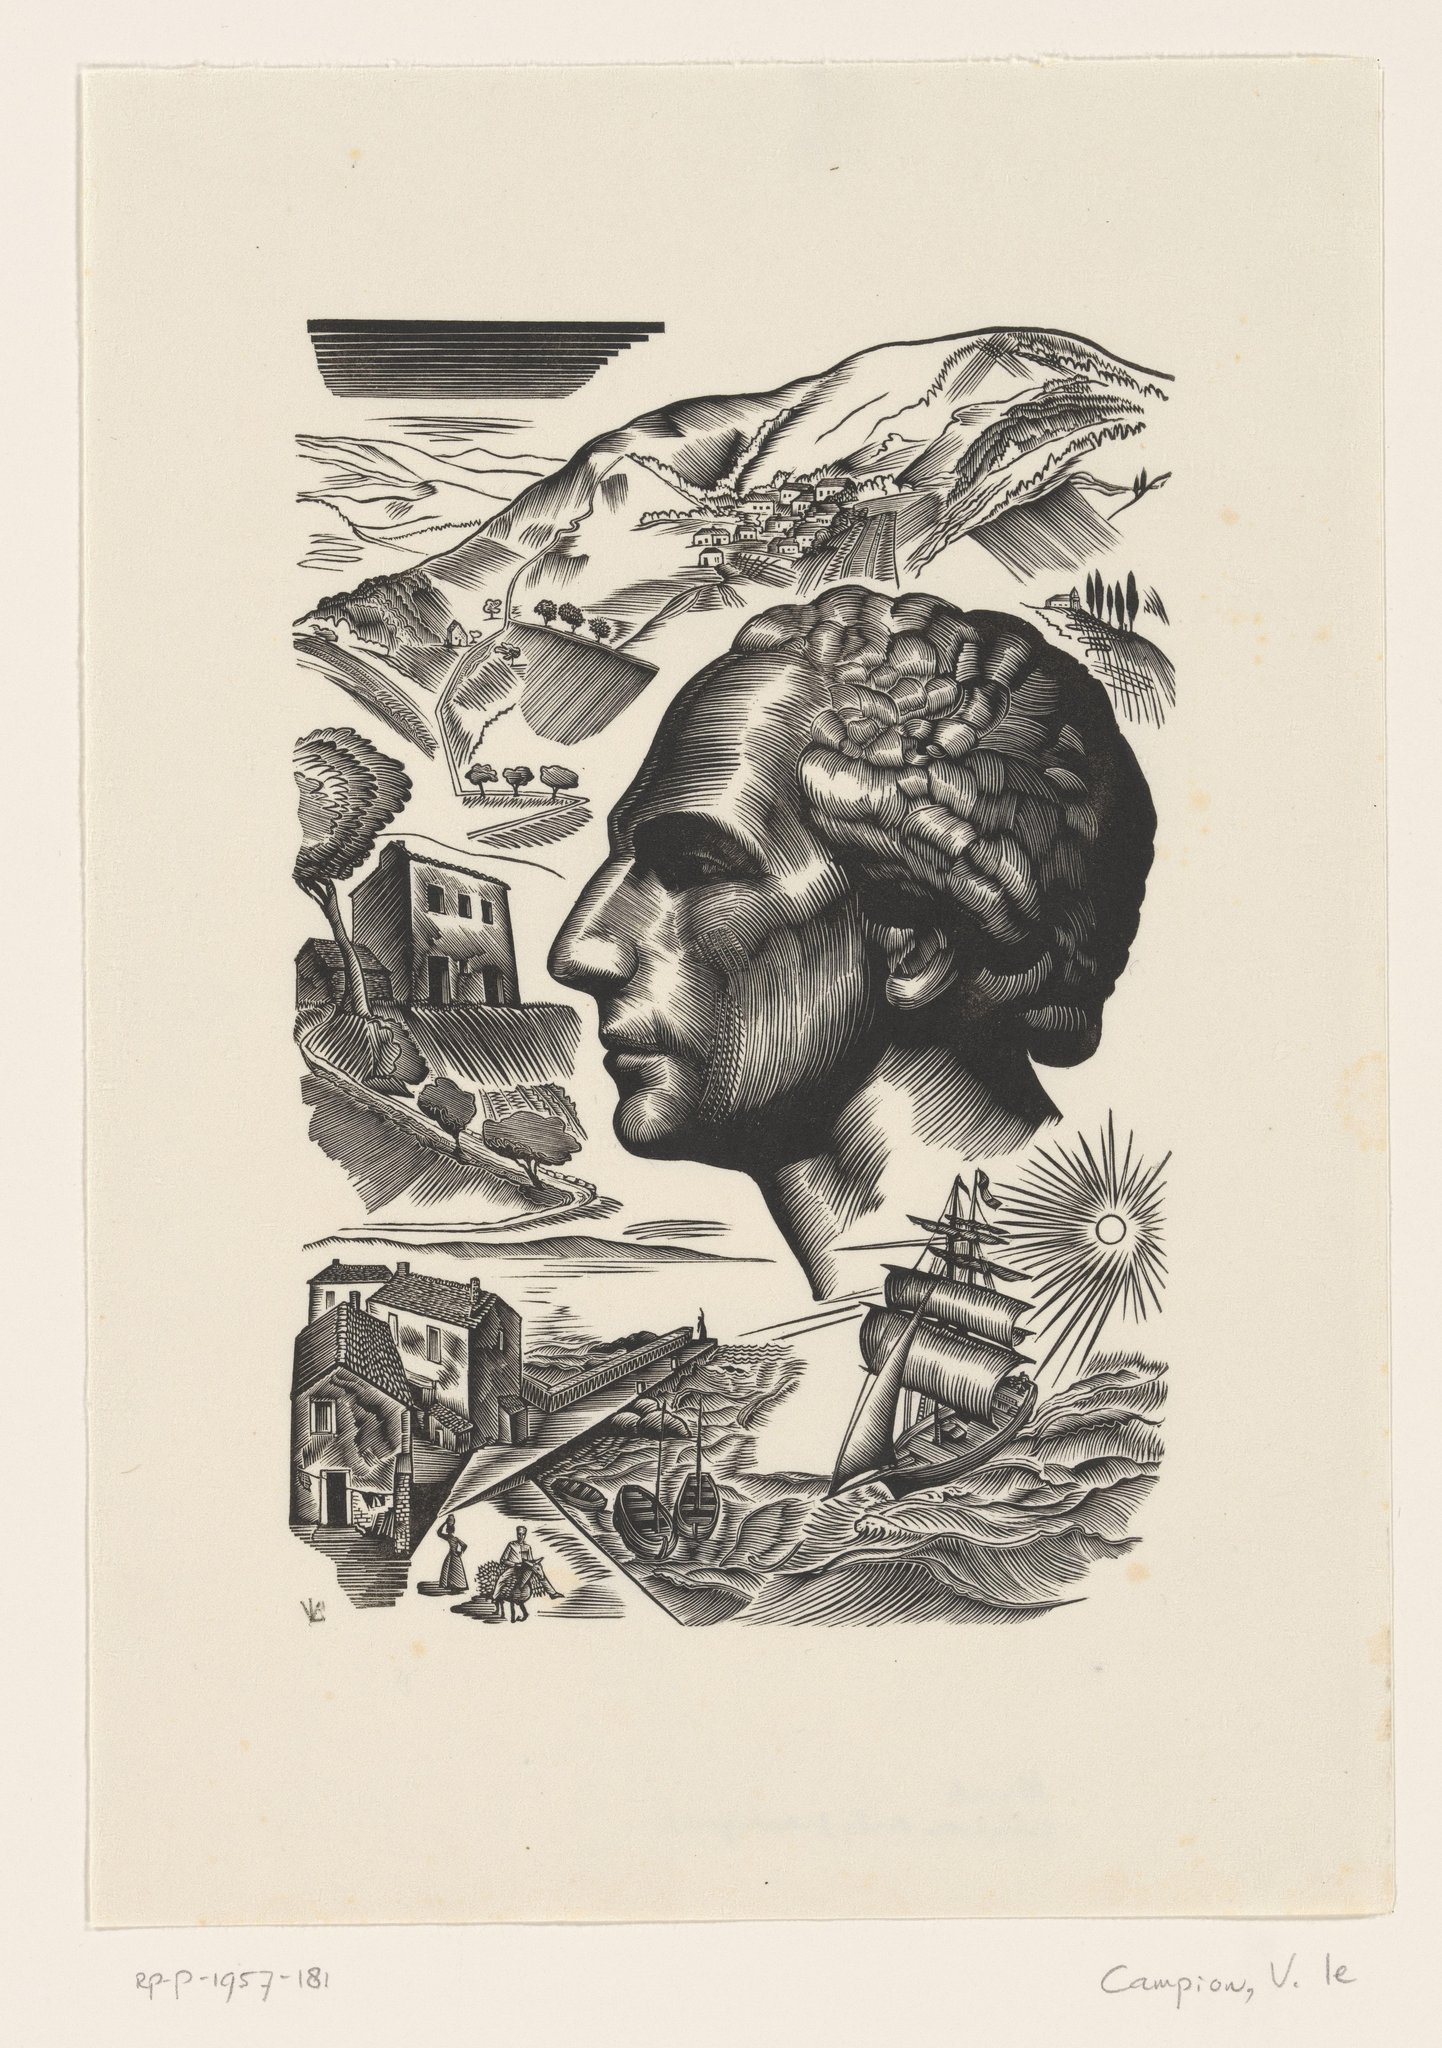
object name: print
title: Portret van onbekende man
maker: valentin le campion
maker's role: print maker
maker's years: 1861-1952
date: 1871-1952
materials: paper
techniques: engraving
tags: historical persons, ships (in general), mountains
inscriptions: annotation: ‘Hans/ uitgever Arts graphiques’, collector's mark: Lugt 2228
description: Misschien betreft het ene Hans, uitgever van "Arts Graphiques".